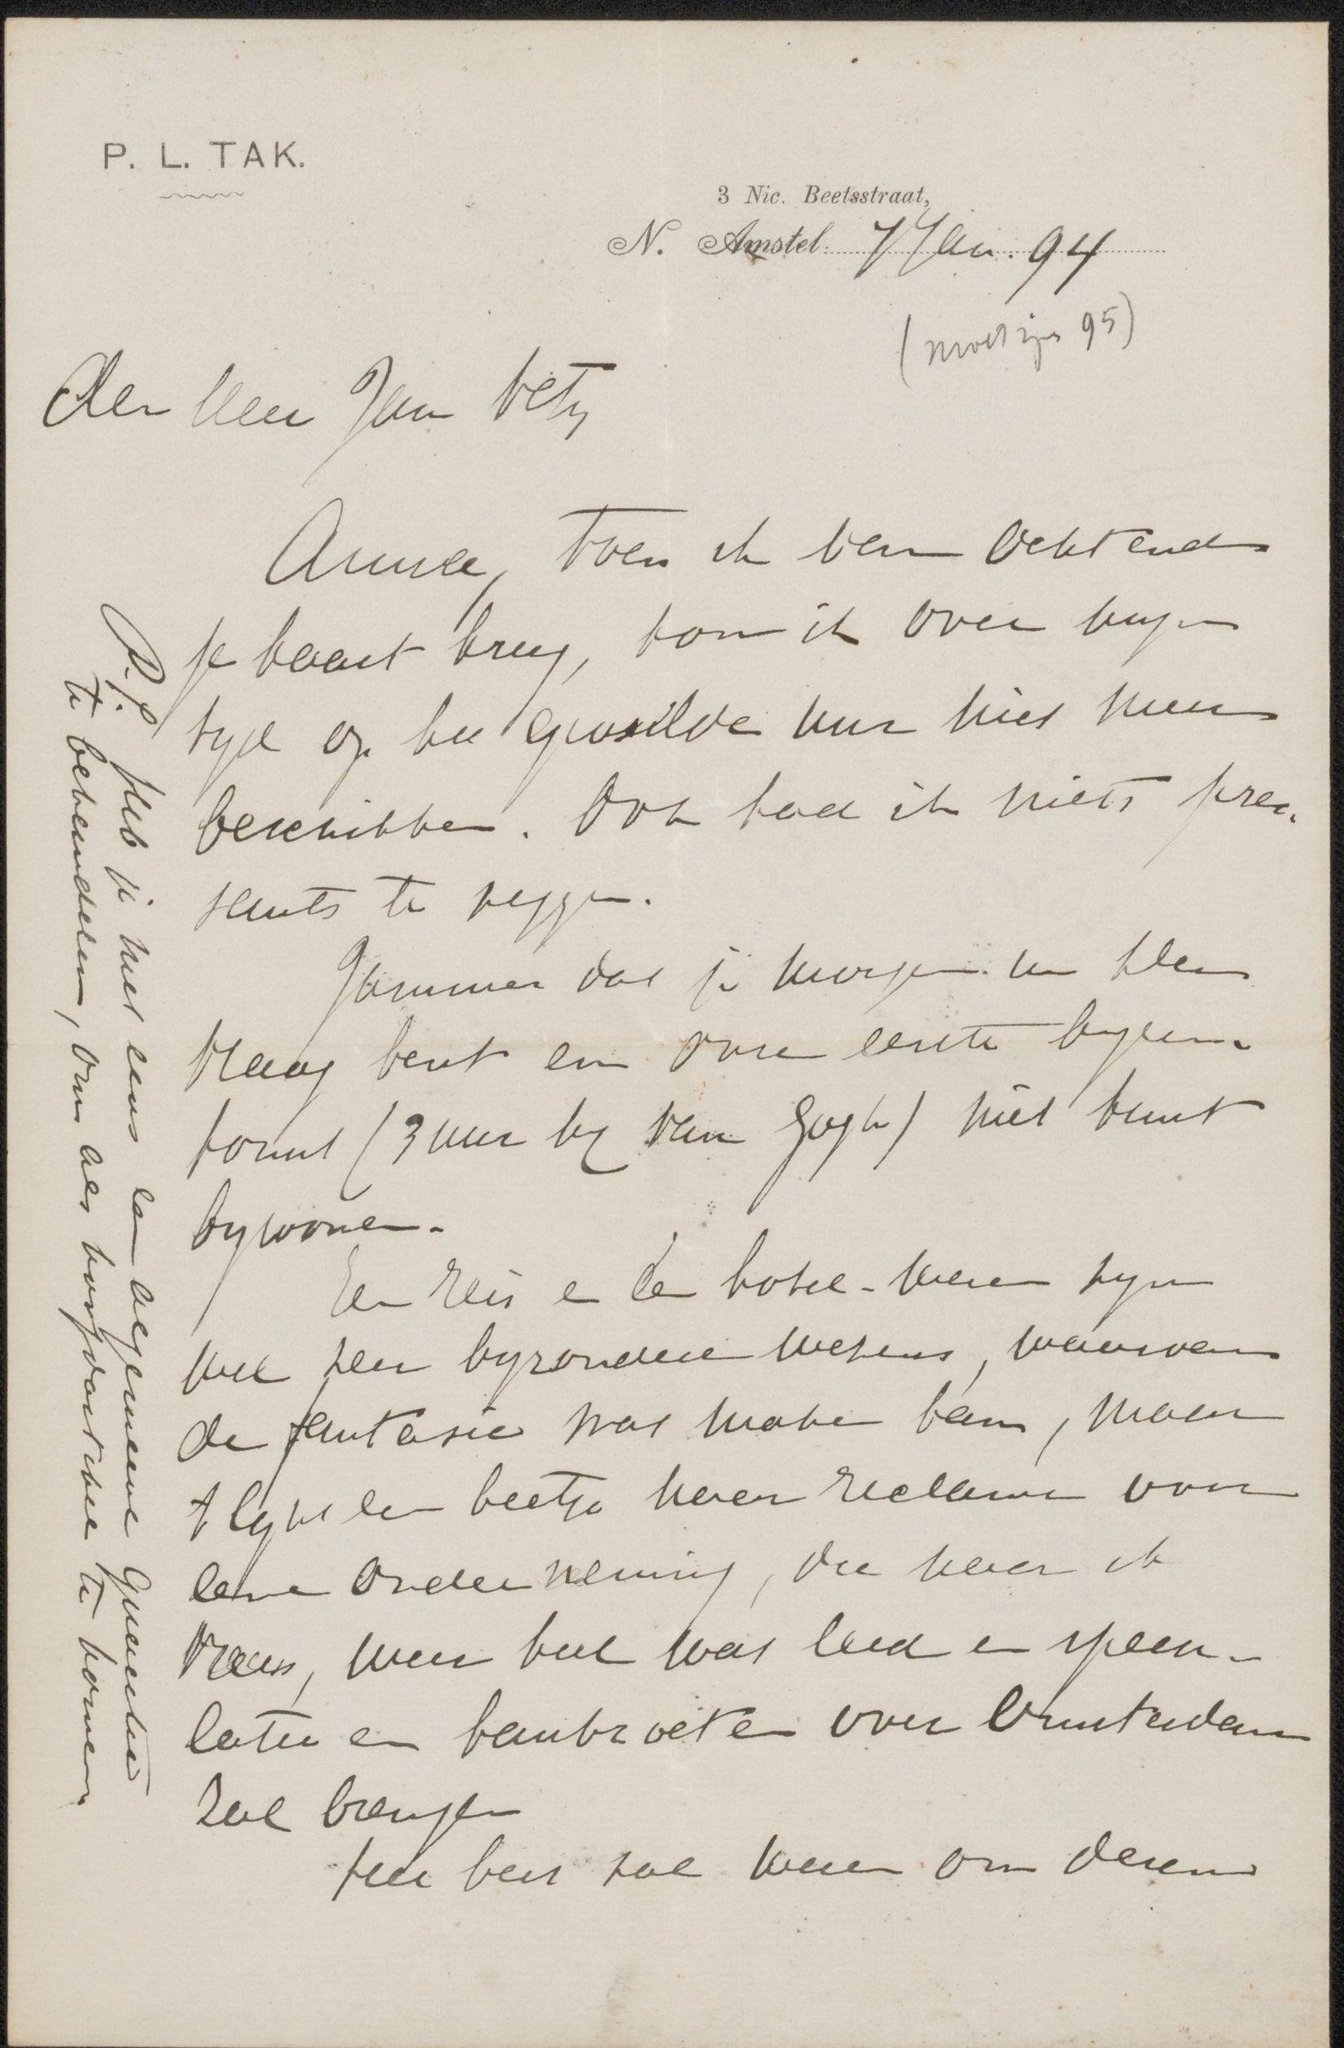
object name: letter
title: Brief aan Jan Veth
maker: pieter lodewijk tak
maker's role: politician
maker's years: 1848-1907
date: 1894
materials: ink, paper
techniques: pen, printing, writing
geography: nieuwer-amstel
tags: dordrecht, amsterdam, painter, print maker, draughtsman, designer, jan veth, hendrik willem mesdag, jonkheer alexander frederik de savornin lohman, ghent, maurice maeterlinck, rotterdam, leiden, utrecht, the graphic arts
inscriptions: collector's mark: ‘RPK’, watermark